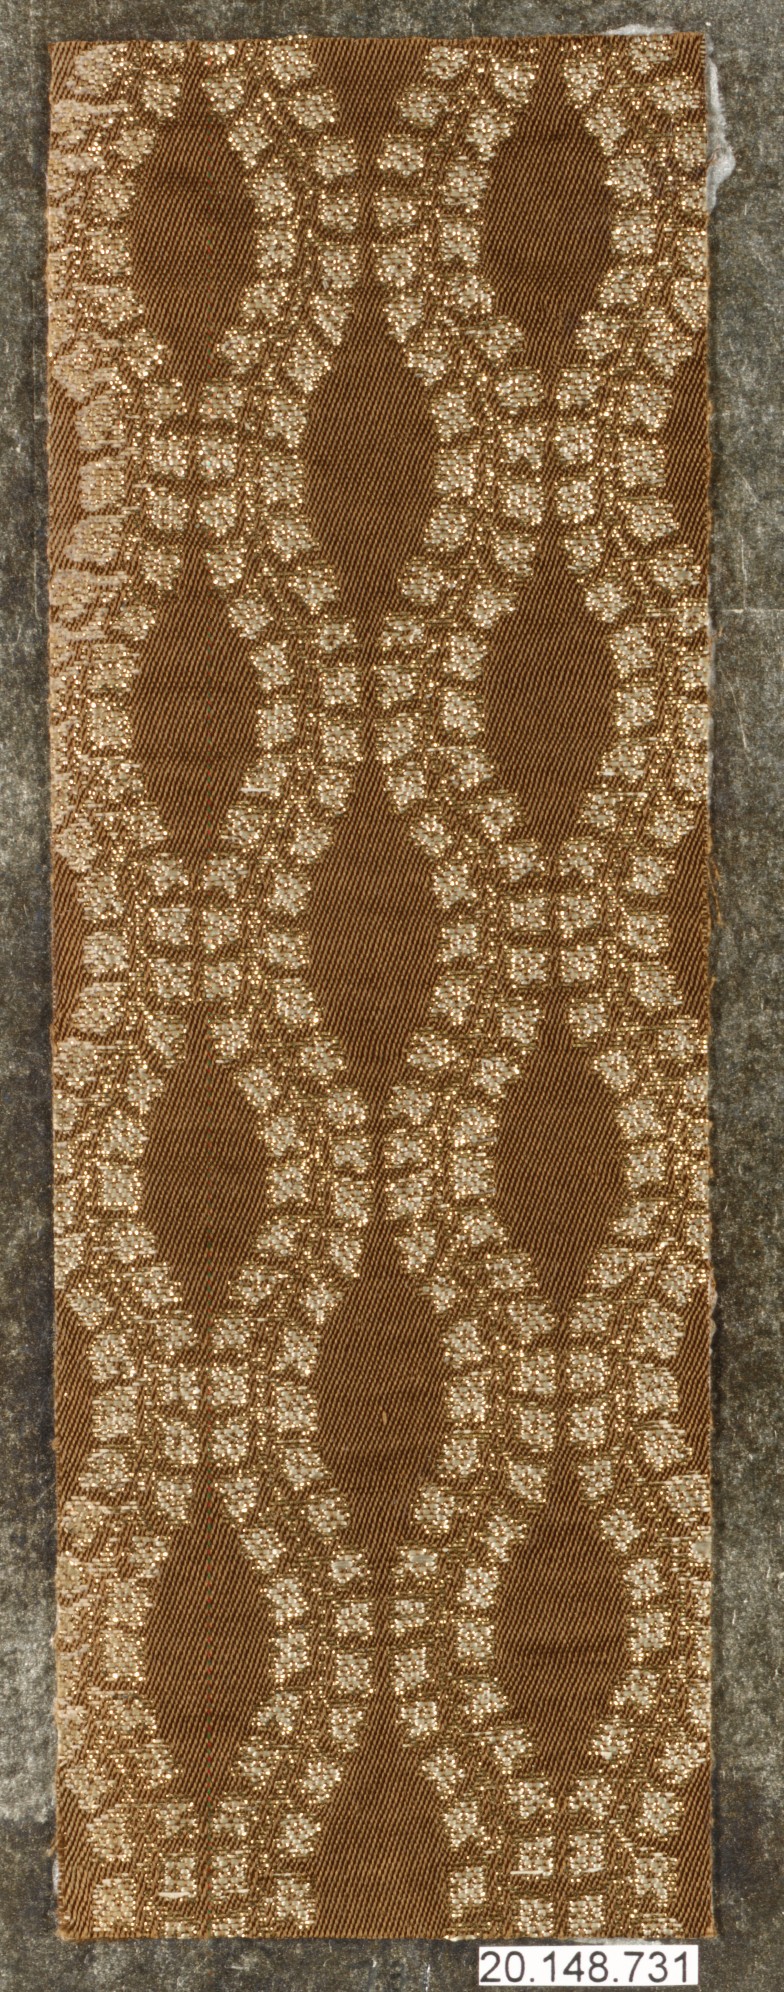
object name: piece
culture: japanese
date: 1701-1800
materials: silk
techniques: compound weave